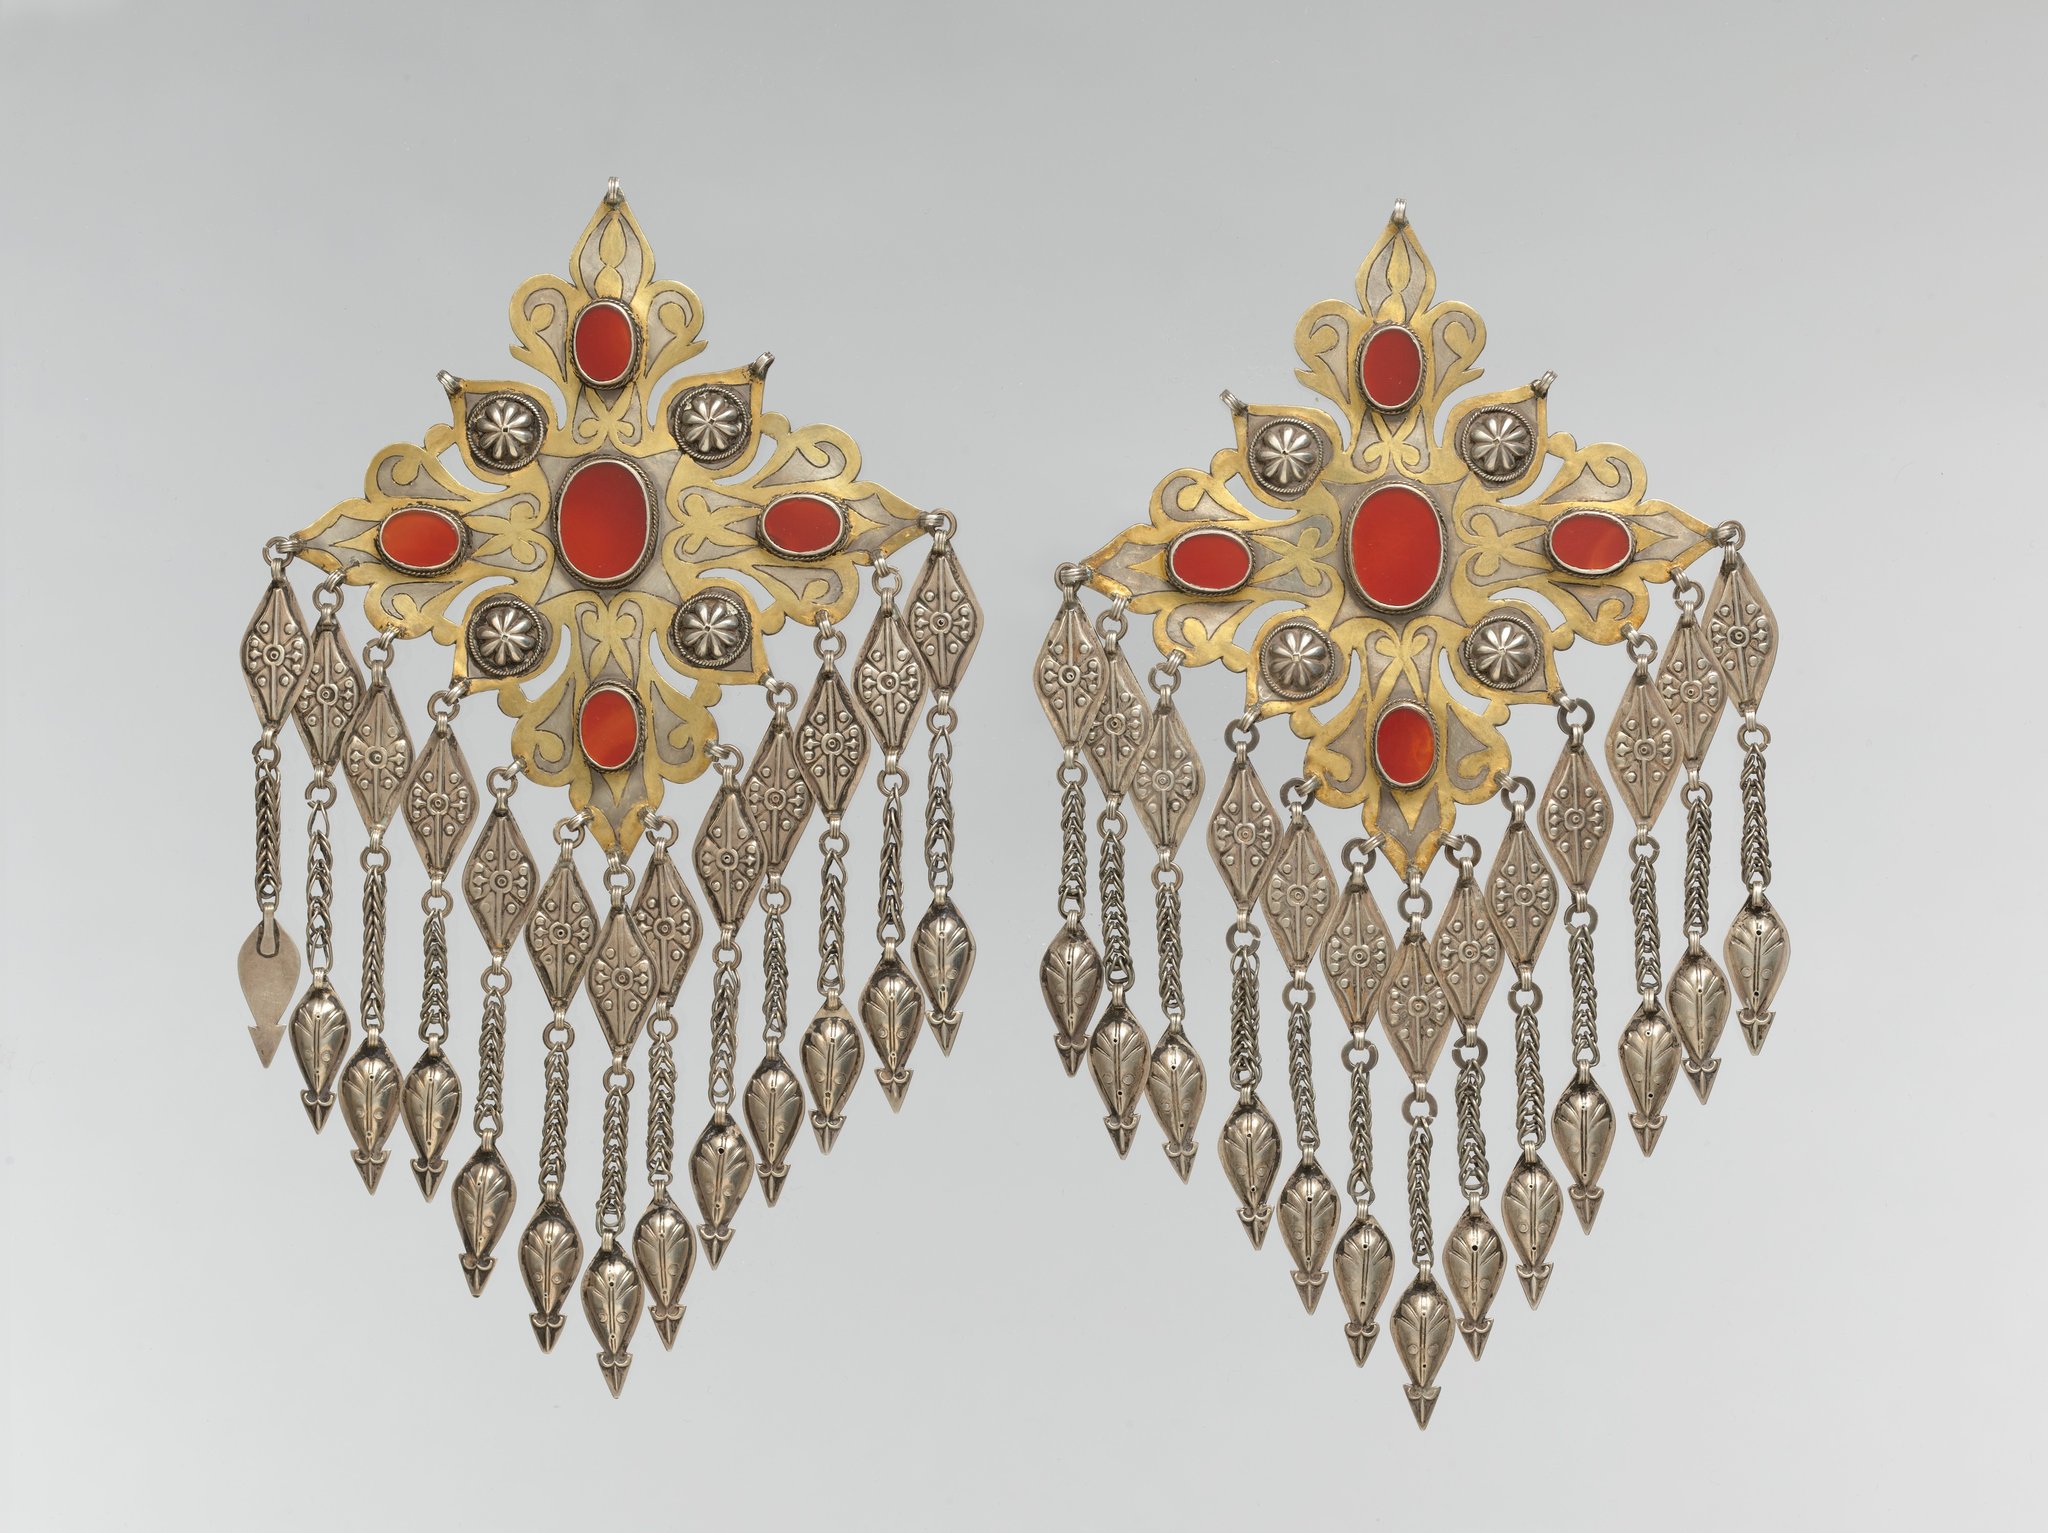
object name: ornament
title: Teke Floral Pectoral Ornament, One of a Pair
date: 1867-1933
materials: carnelian, silver, metal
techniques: chasing, cutting, gilding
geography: central asia